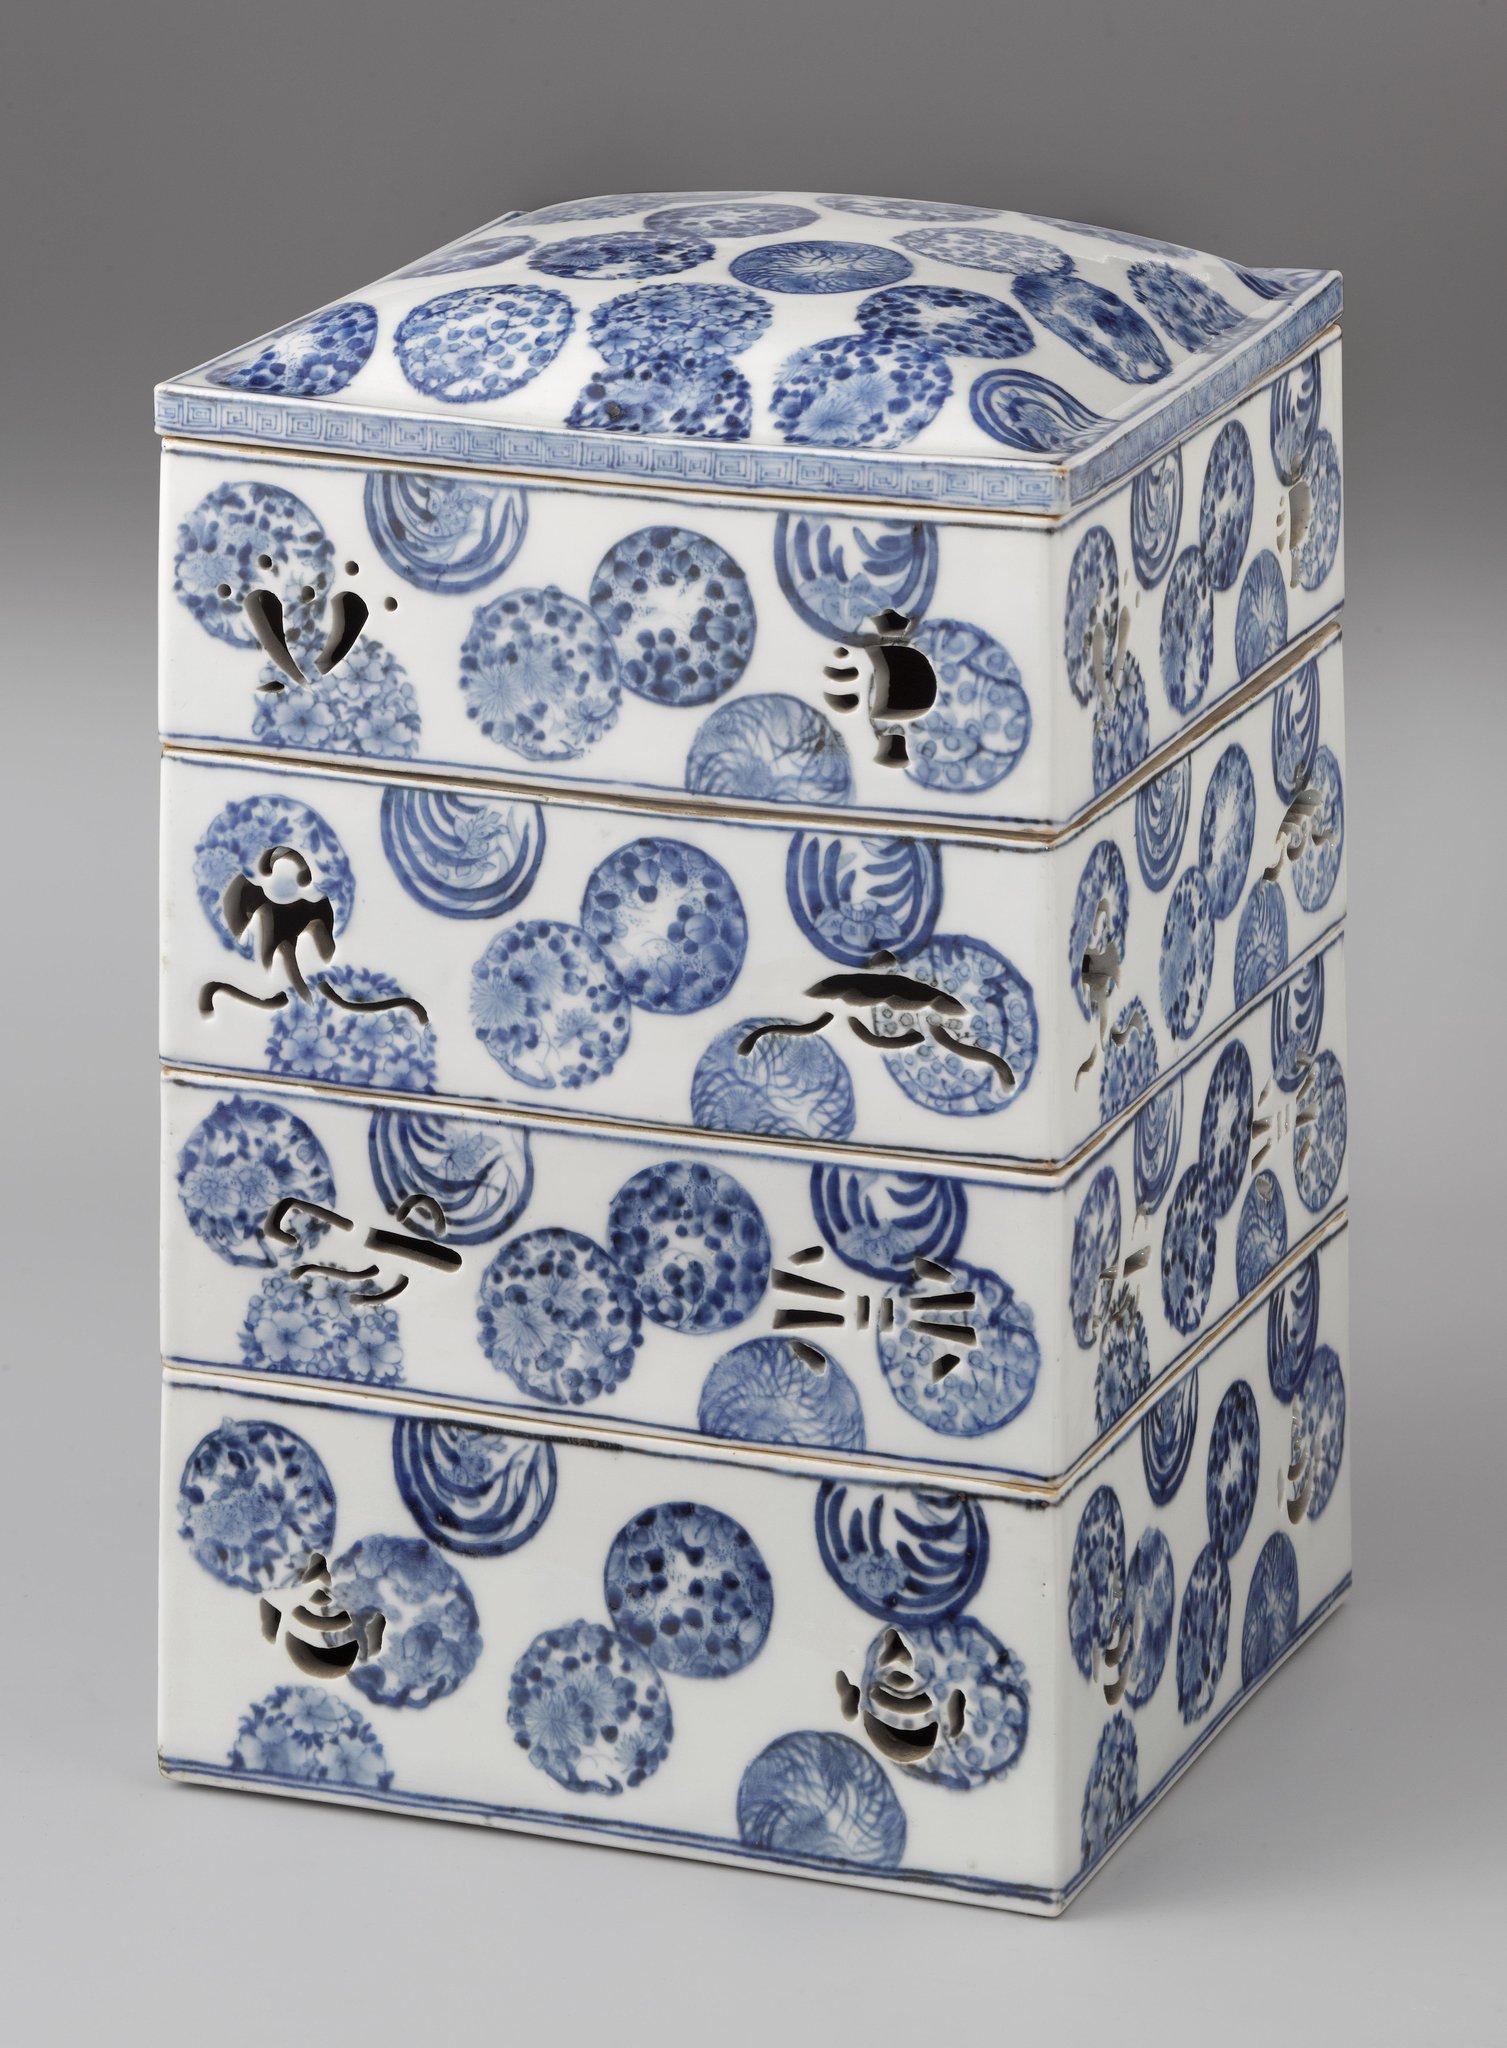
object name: stapeldoos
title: Square tiered box with cover with medallions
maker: Anonymous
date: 1775-1824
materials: cobalt, glaze, paint, porcelain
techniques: embroidery, firing, forming, vitrification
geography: japan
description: Onderste doos van vierkante stapeldoos (jubako) met deksel van porselein bestaande uit vier lagen met opengewerkte wanden in verschillende vormen, beschilderd in onderglazuur blauw. Op de wanden medaillons gevormd uit verschillende bloemranken (prunus, chrysant, pioen, orchidee, lelie, etc.). Op de rand van de deksel een meanderpatroon. Blauw-wit.